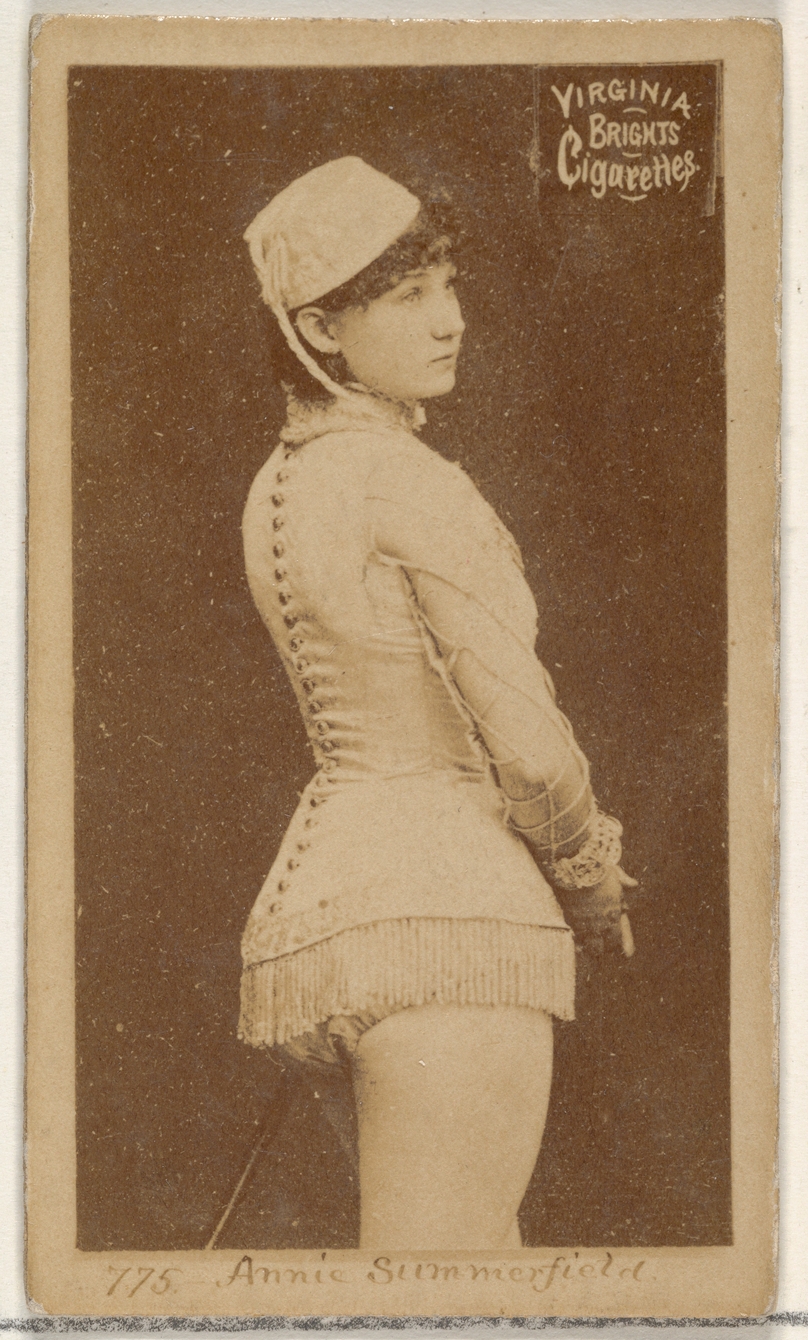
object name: photograph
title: Card 775, Annie Summerfield, from the Actors and Actresses series (N45, Type 2) for Virginia Brights Cigarettes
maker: allen & ginter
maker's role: publisher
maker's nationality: american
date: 1888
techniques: albumen silver print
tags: portraits,women,actresses